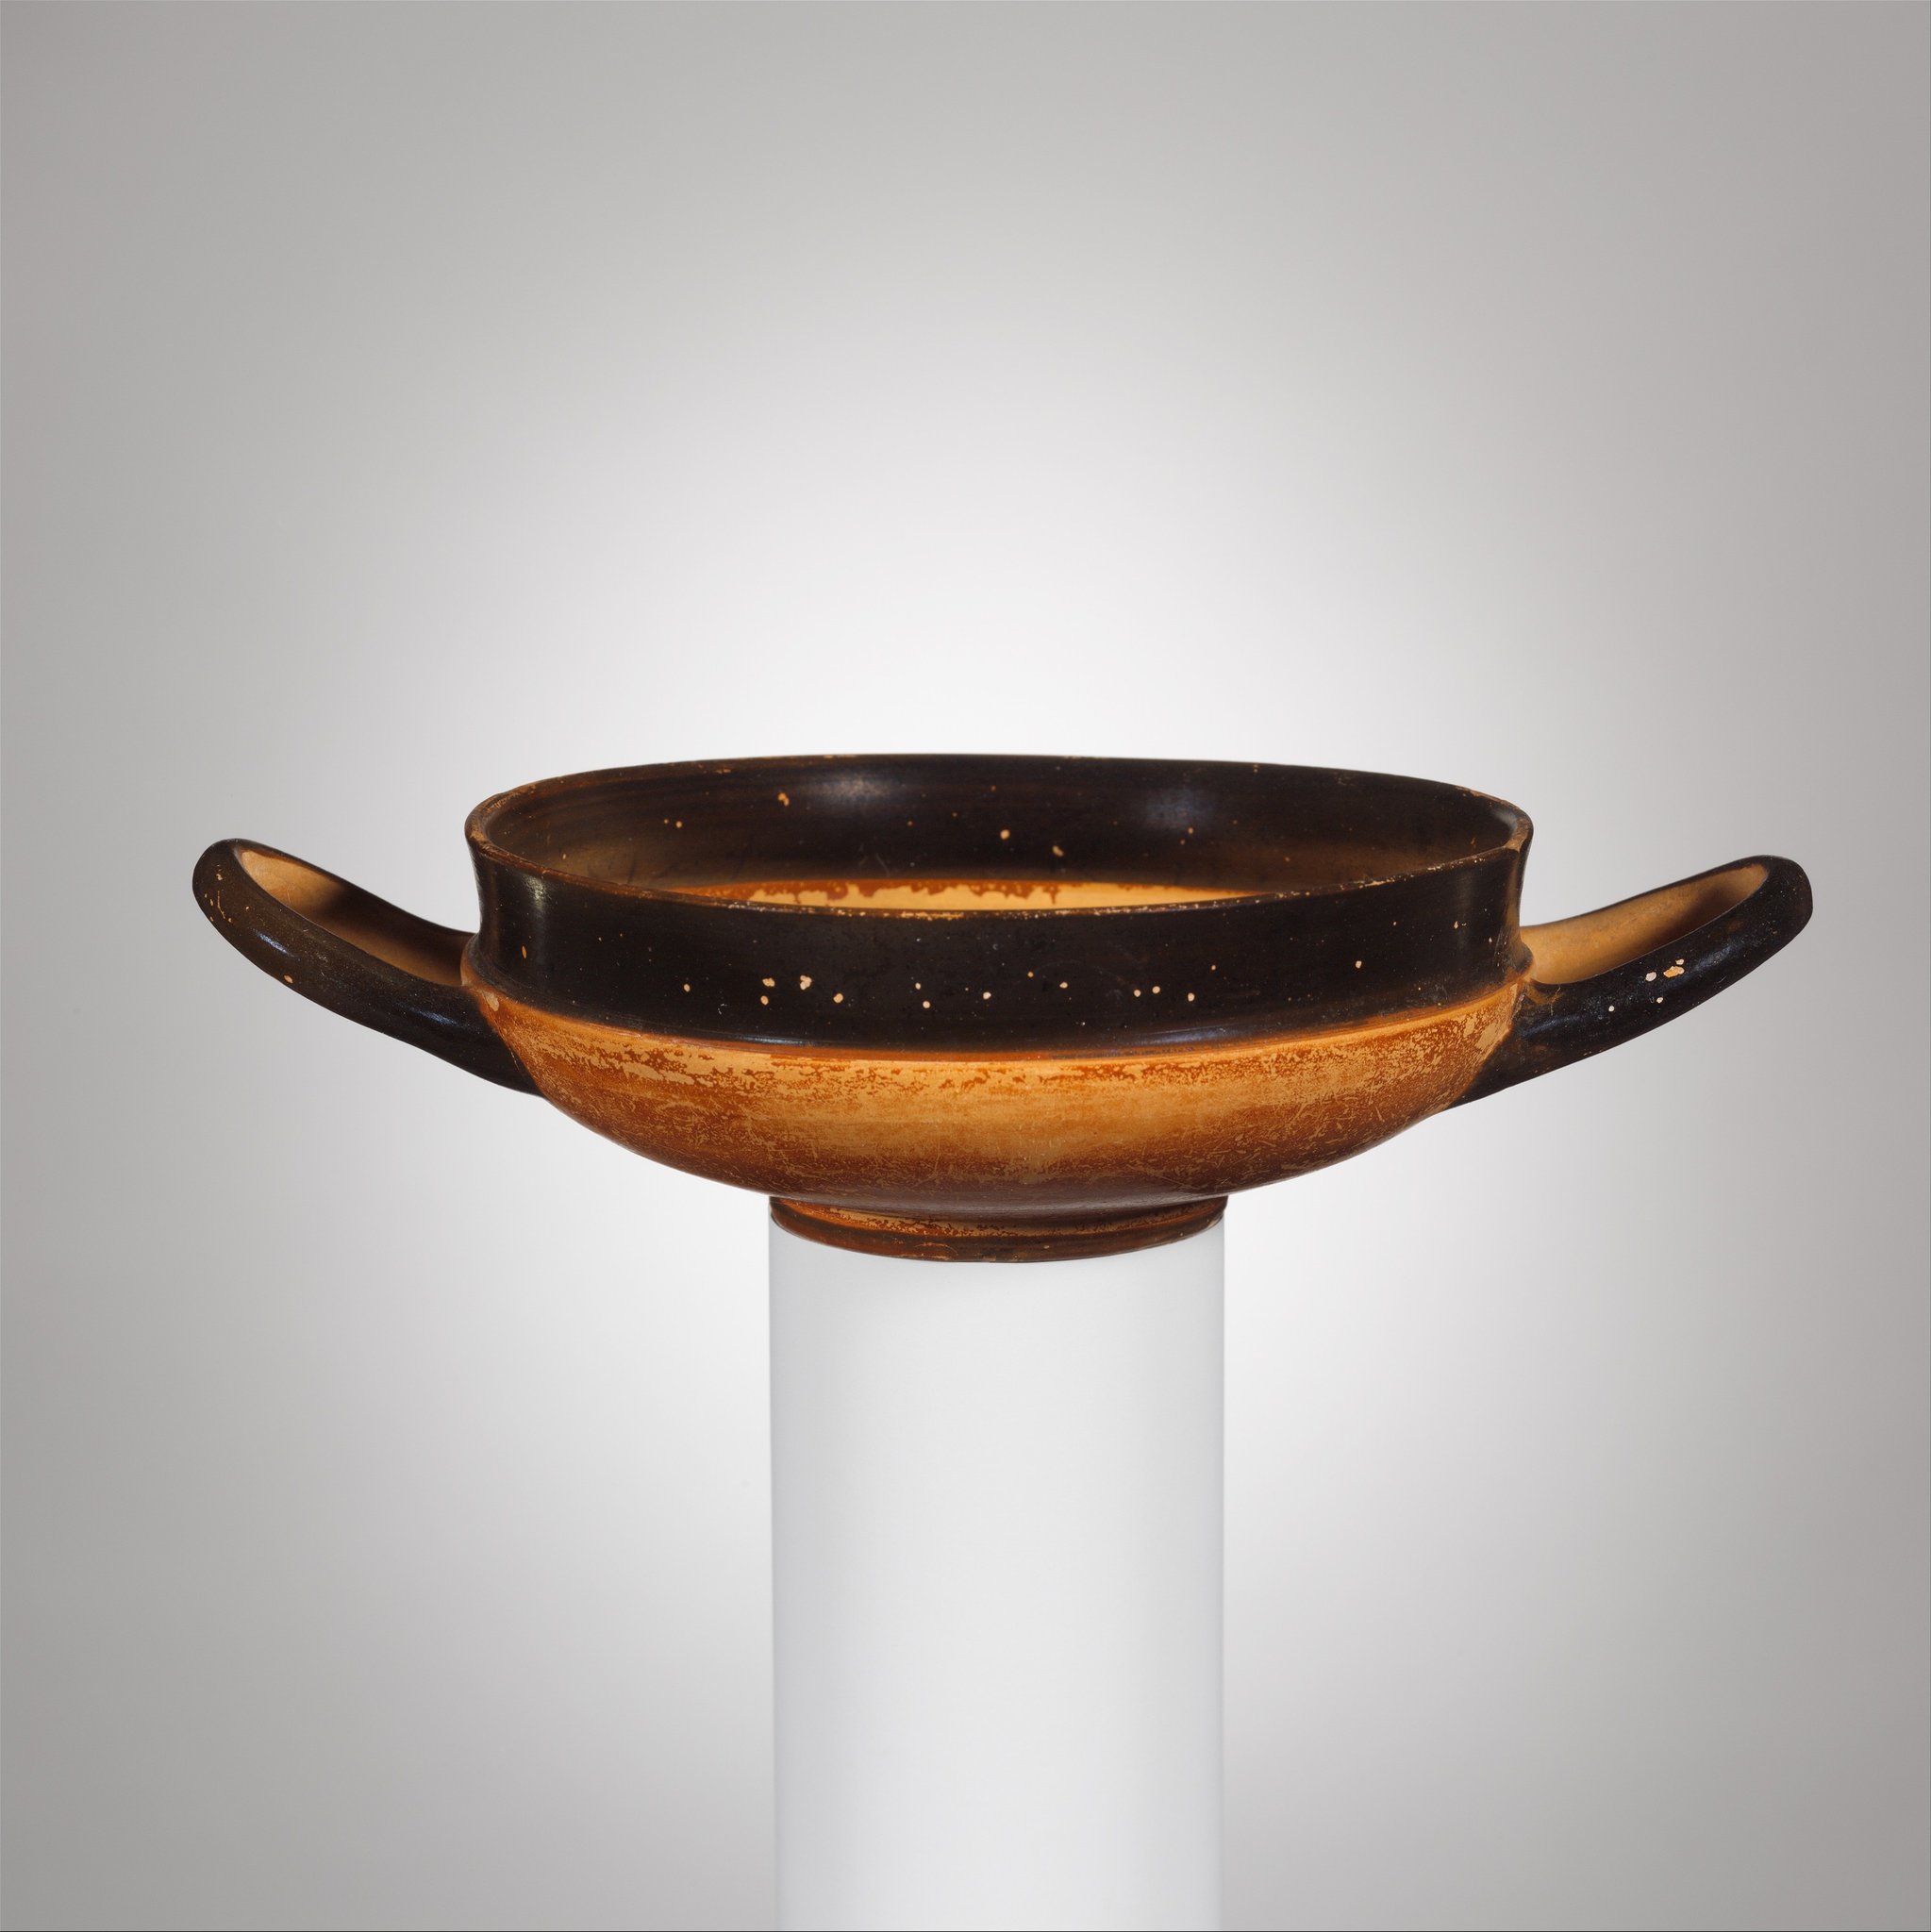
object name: kylix, stemless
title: Terracotta stemless kylix (drinking cup)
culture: greek, attic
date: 500-475 BCE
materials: terracotta